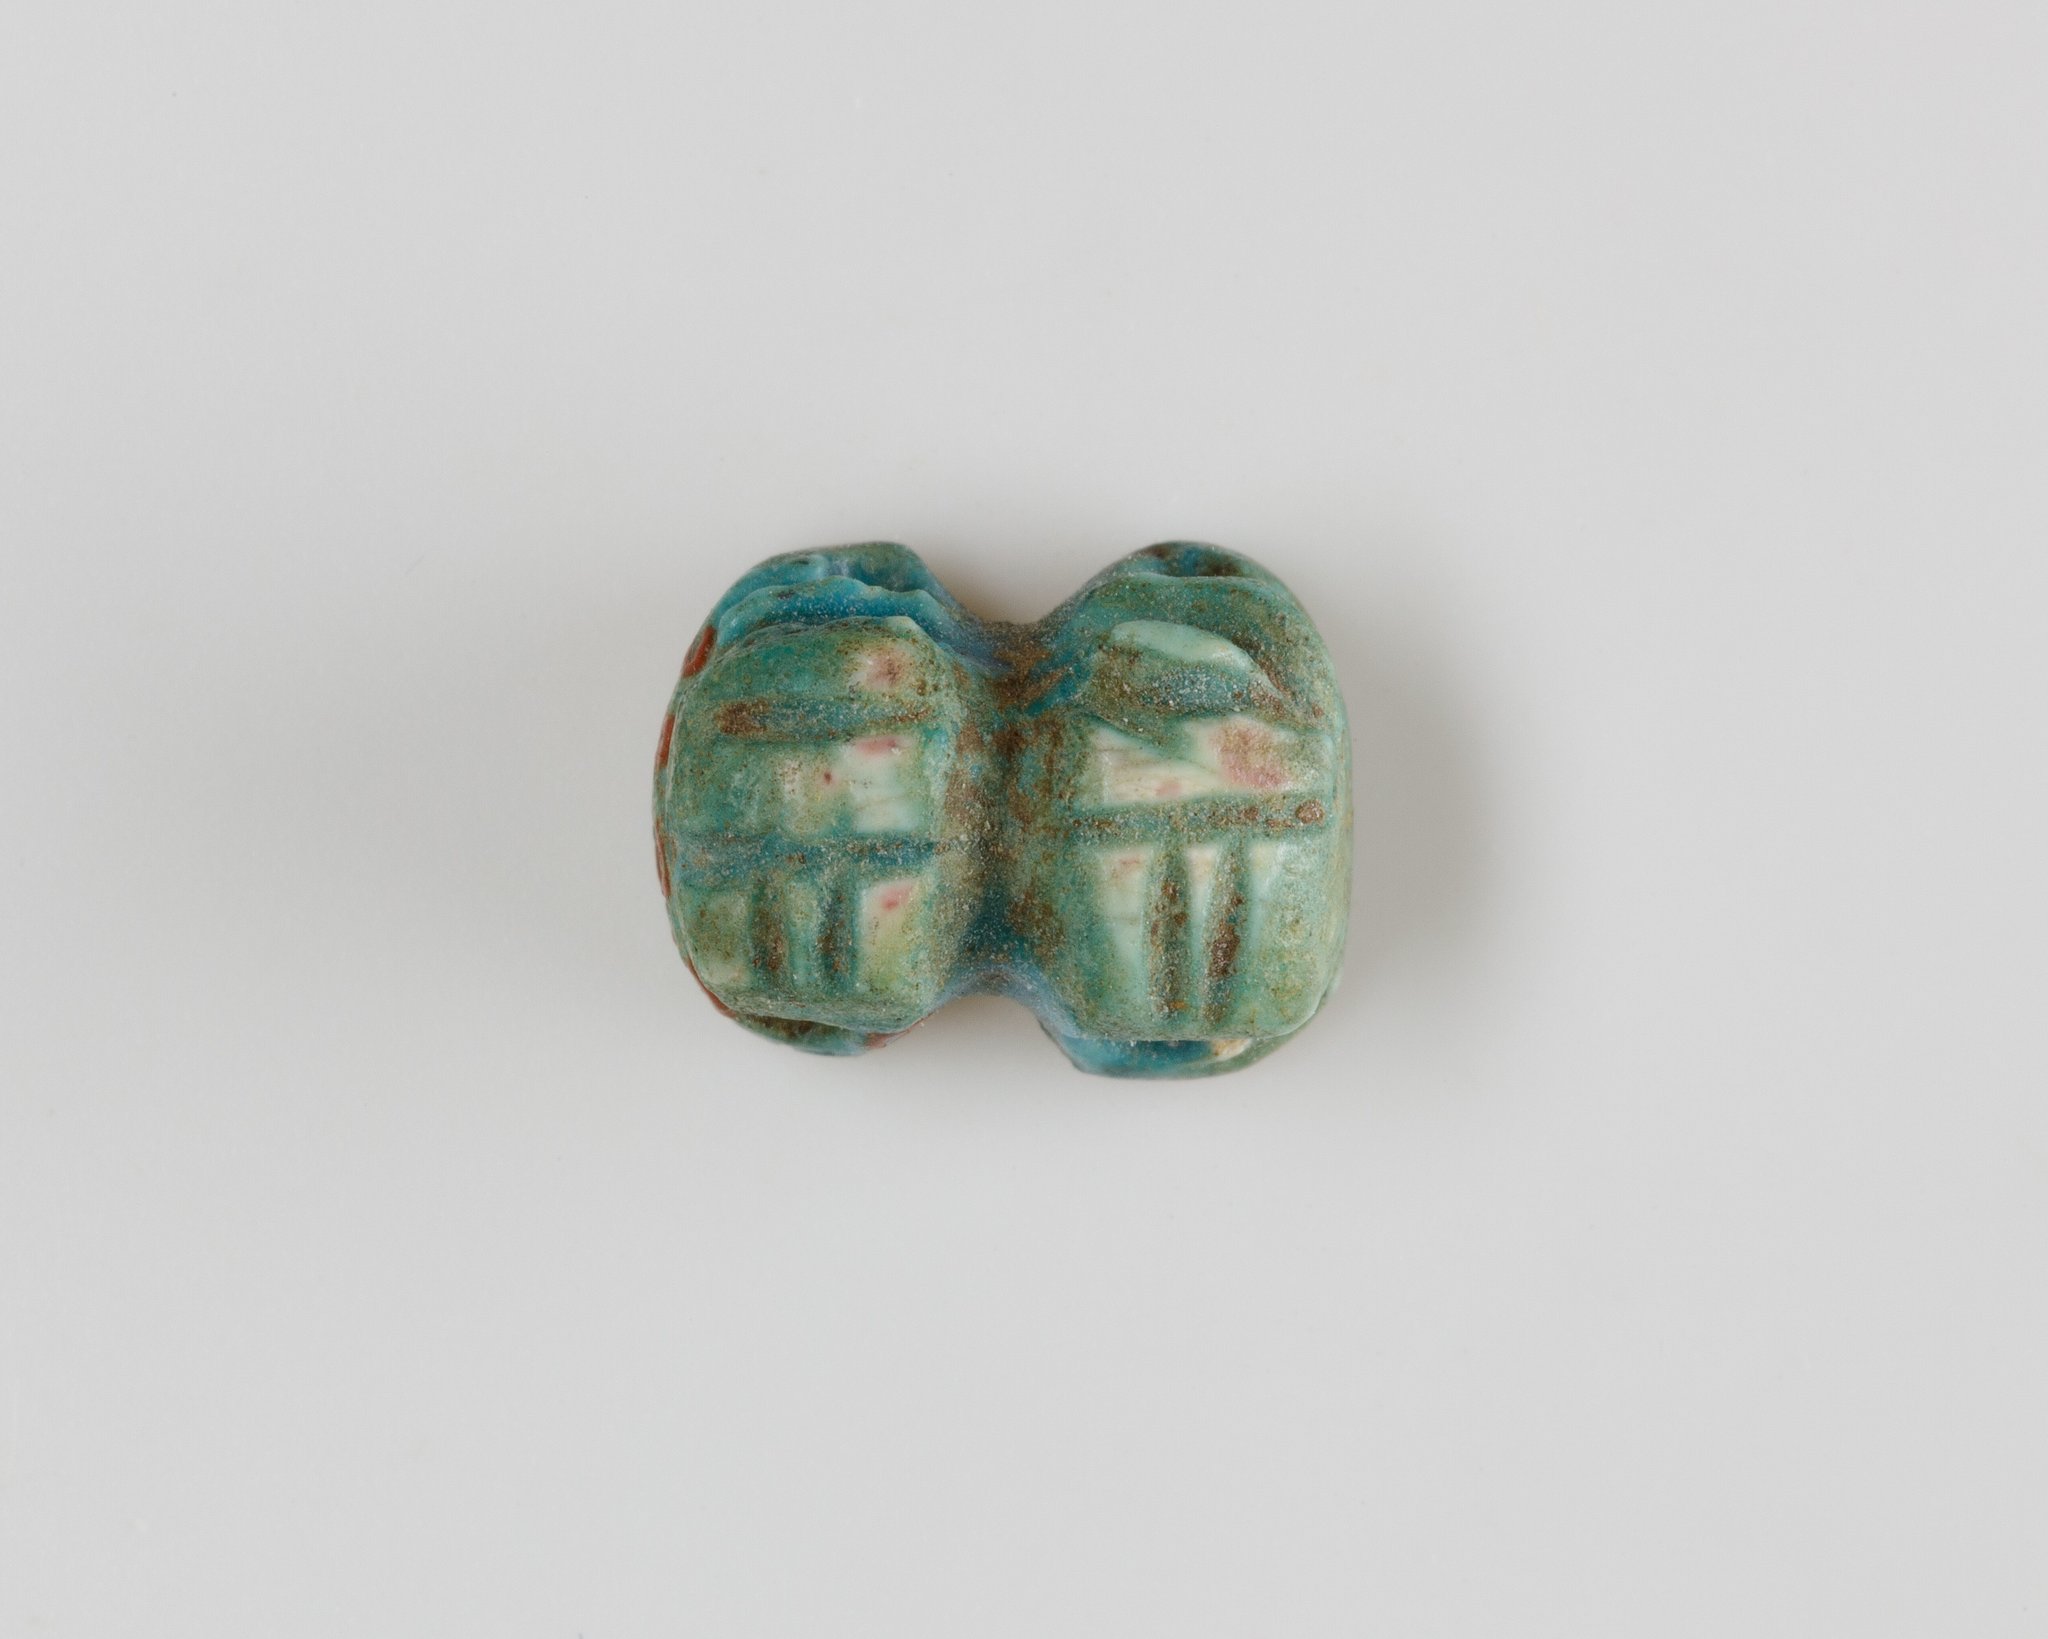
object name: scarab, double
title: Double Scarab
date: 1492-1473 BCE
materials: stone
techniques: glazing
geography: egypt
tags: scarabs